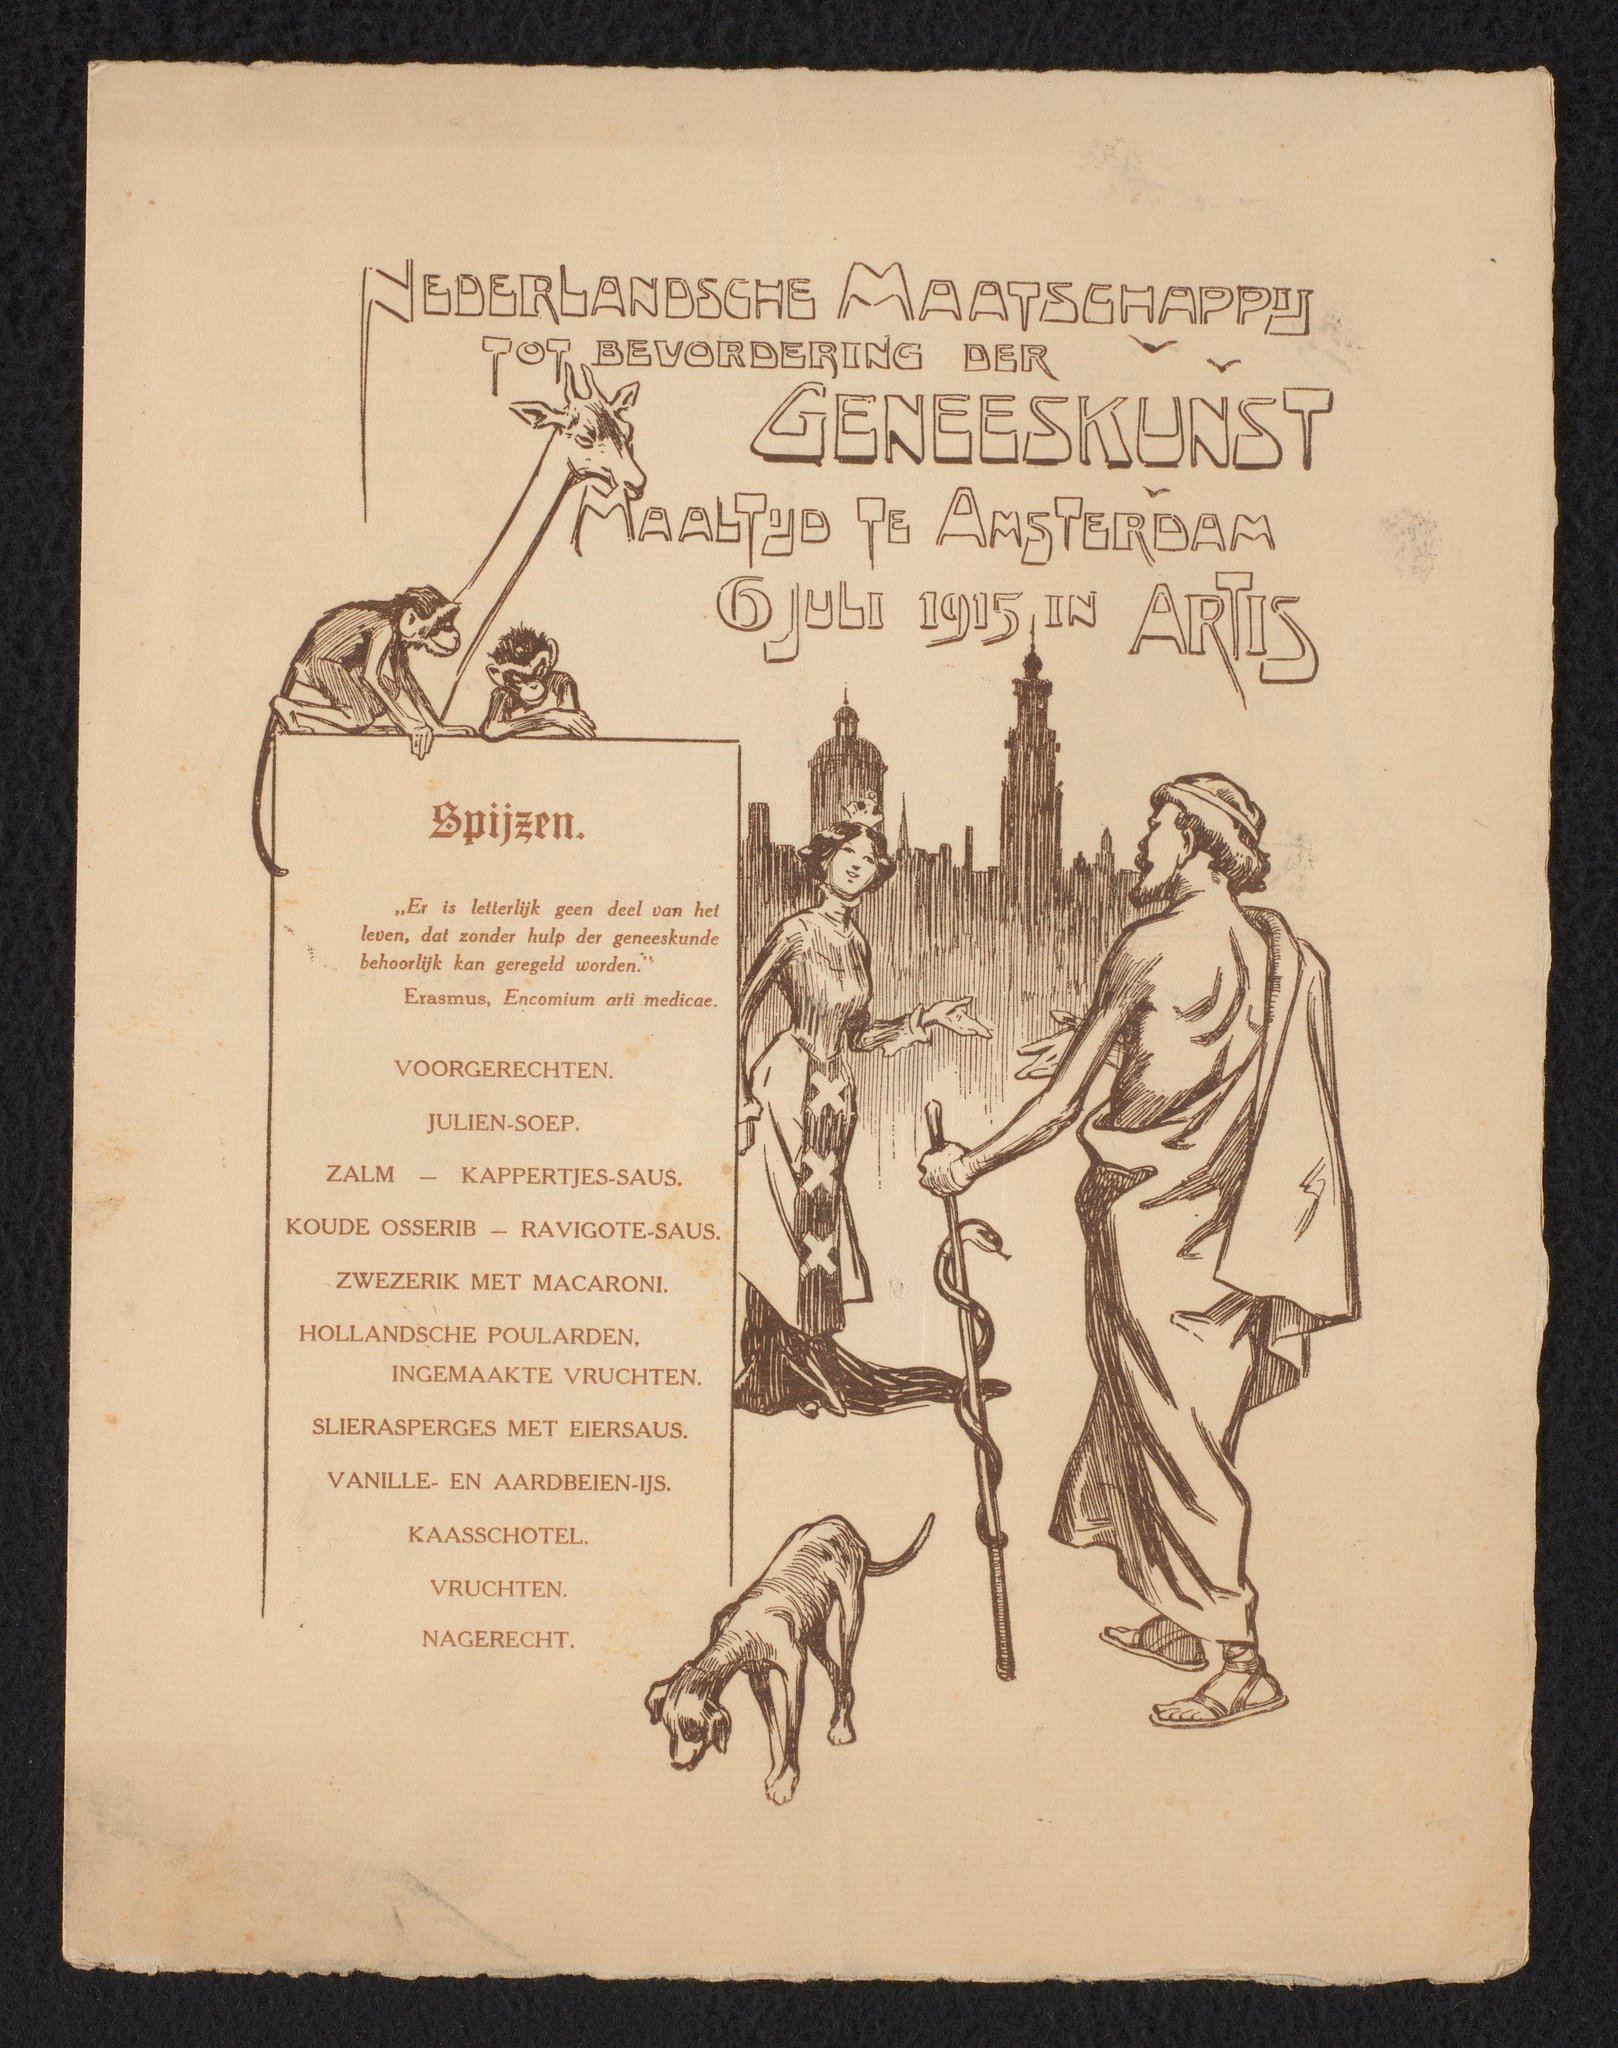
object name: menu, menukaart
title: Menu voor de maaltijd van de Nederlandsche Maatschappij tot bevordering der Geneeskunst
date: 1915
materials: paper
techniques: letterpress printing, printing block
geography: amsterdam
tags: musician at work, banquet of elegant company (+ toast at meal, banquet), bones in general (human body)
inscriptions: collector's mark: Lugt 2228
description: Menu voor een diner op 6 juli 1915 in Artis. Op de voorzijde het menu, bij een vrouwenfiguur met op haar rok het wapen van Amsterdam. Zij gebaart uitnodigend richting de stad terwijl zij kijkt naar de figuur die aan komt lopen, met een caduceus in de linkerhand. Rechts twee apen en een giraffe. Binnenin links een aantal historische wetenschappers die het glas heffen naar elkaar. Daarbij korte teksten en de prijslijst van beschikbare wijnen. Op de rechterzijde binnenin het programma van de muzikale invulling van het diner, met een kader van putti en muzikanten die spelen op menselijke botten.